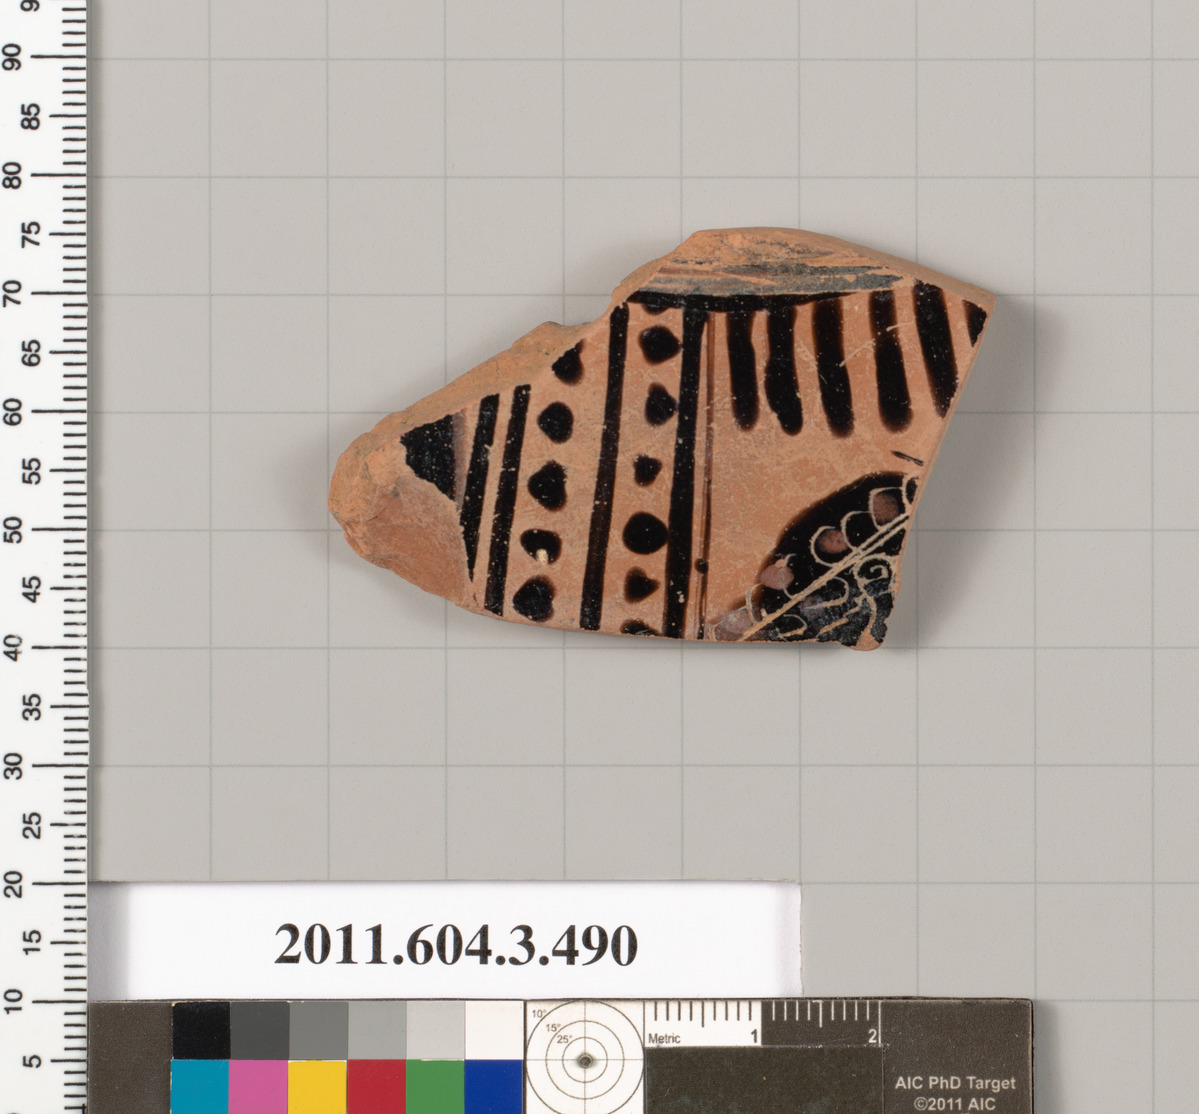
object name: column krater fragment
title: Terracotta fragment of a column-krater (bowl for mixing wine and water)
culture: greek, attic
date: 525-501 BCE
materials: terracotta